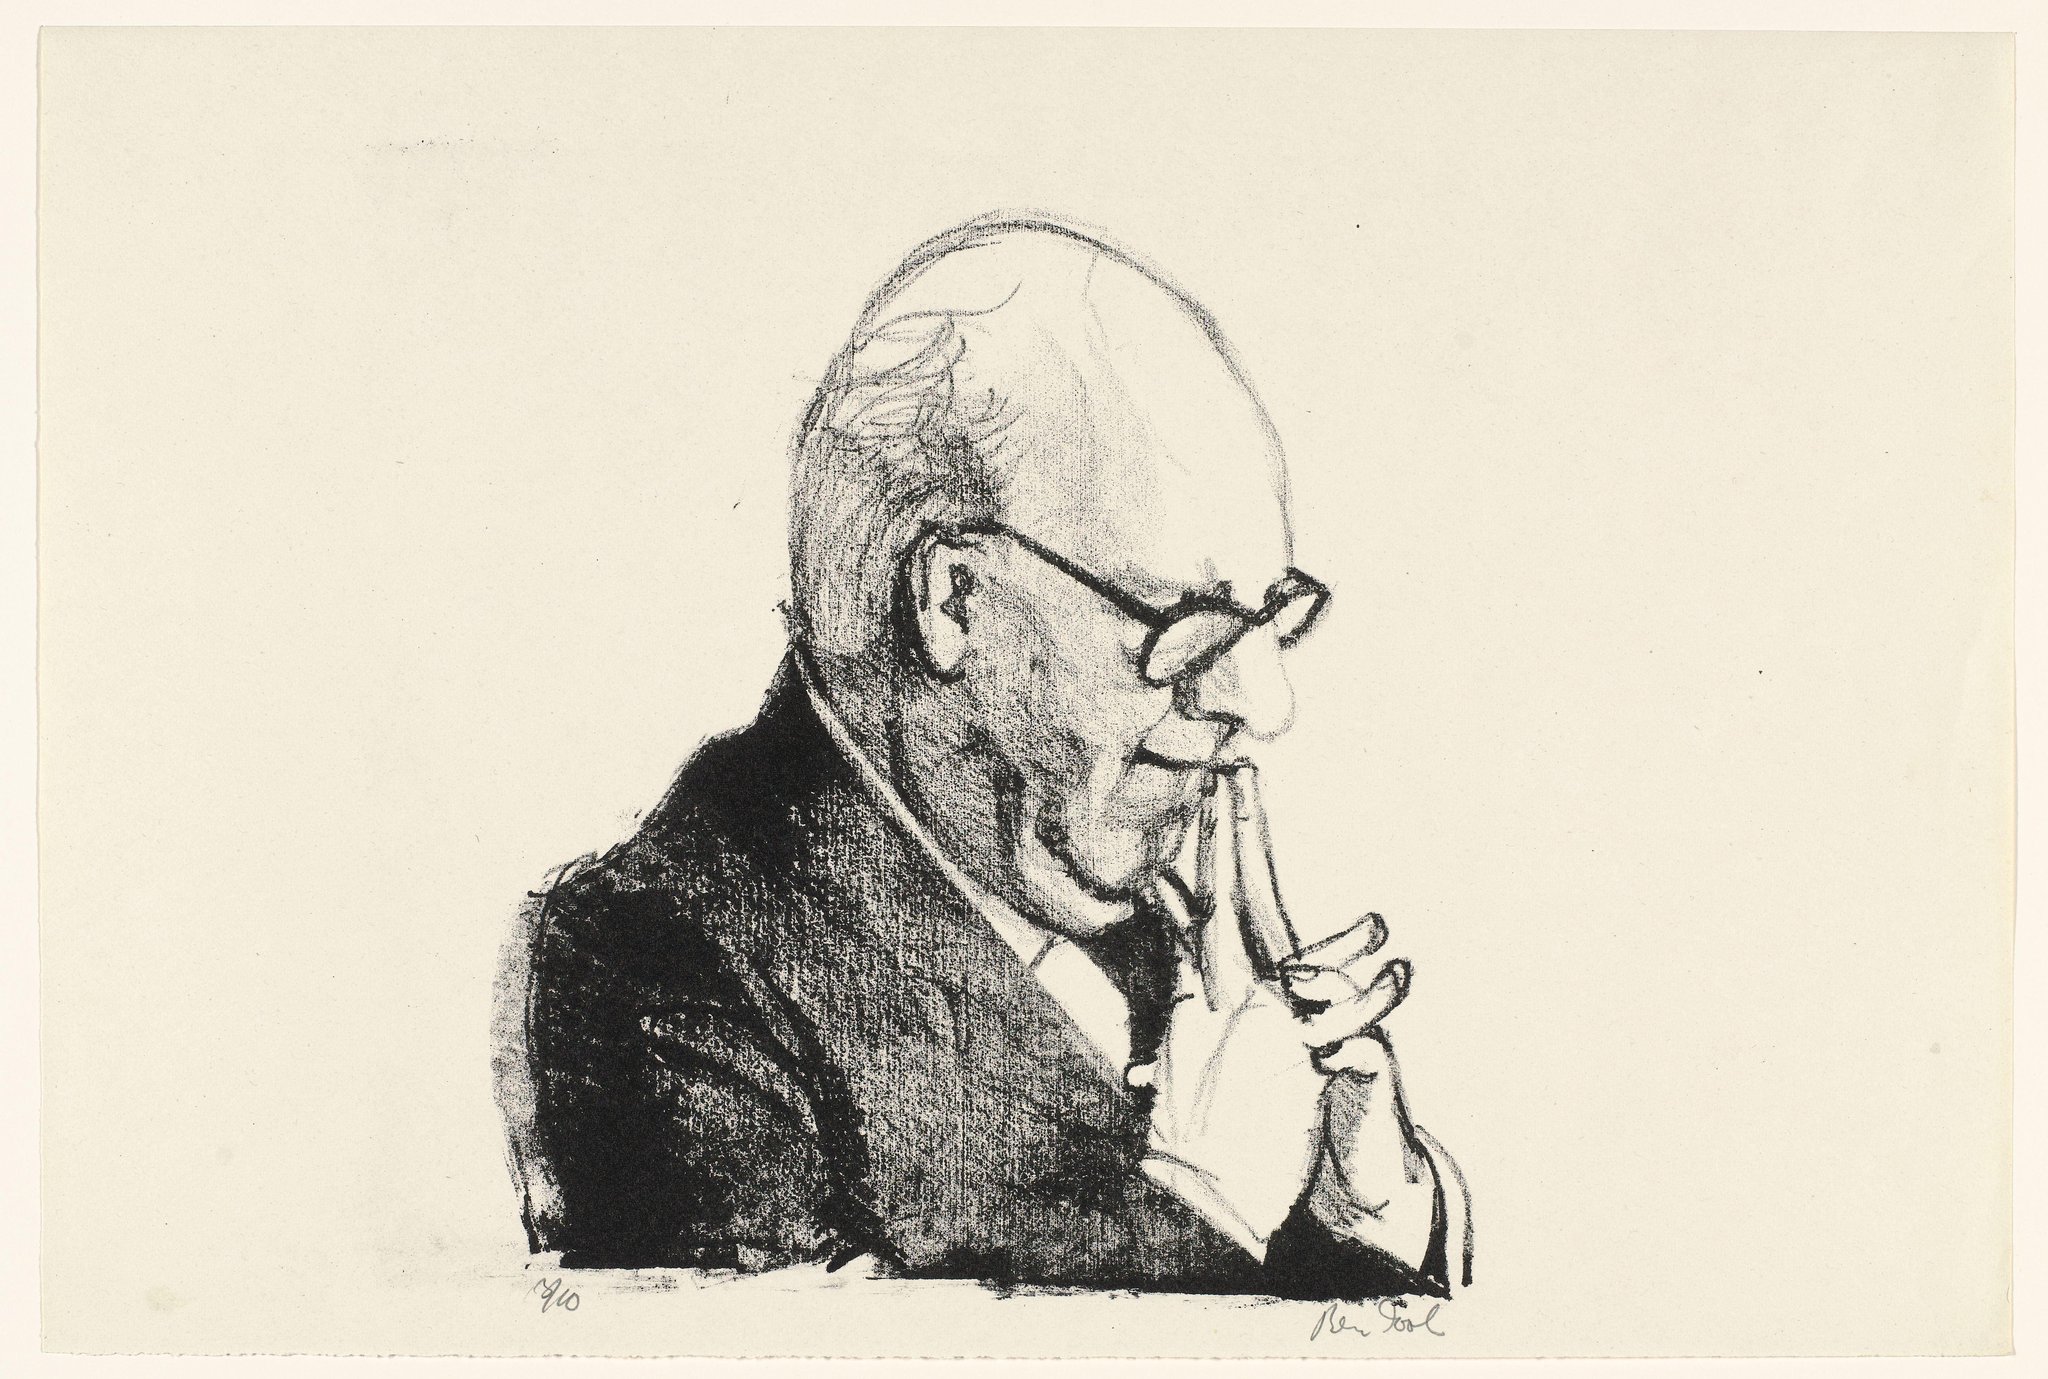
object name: print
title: Portret van Herman Hendrik Maas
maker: rein dool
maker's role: draughtsman, painter, print maker, sculptor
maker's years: 1933-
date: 1976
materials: paper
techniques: lithograph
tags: universiteit van leiden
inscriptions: edition: ‘3/10’, signature and date: ‘Rein Dool 76’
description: Portret van Herman Hendrik Maas, hoogleraaar aan de Universiteit Leiden vanaf 1967 en vanaf 1971 meermaals gekozen in het College van Bestuur.